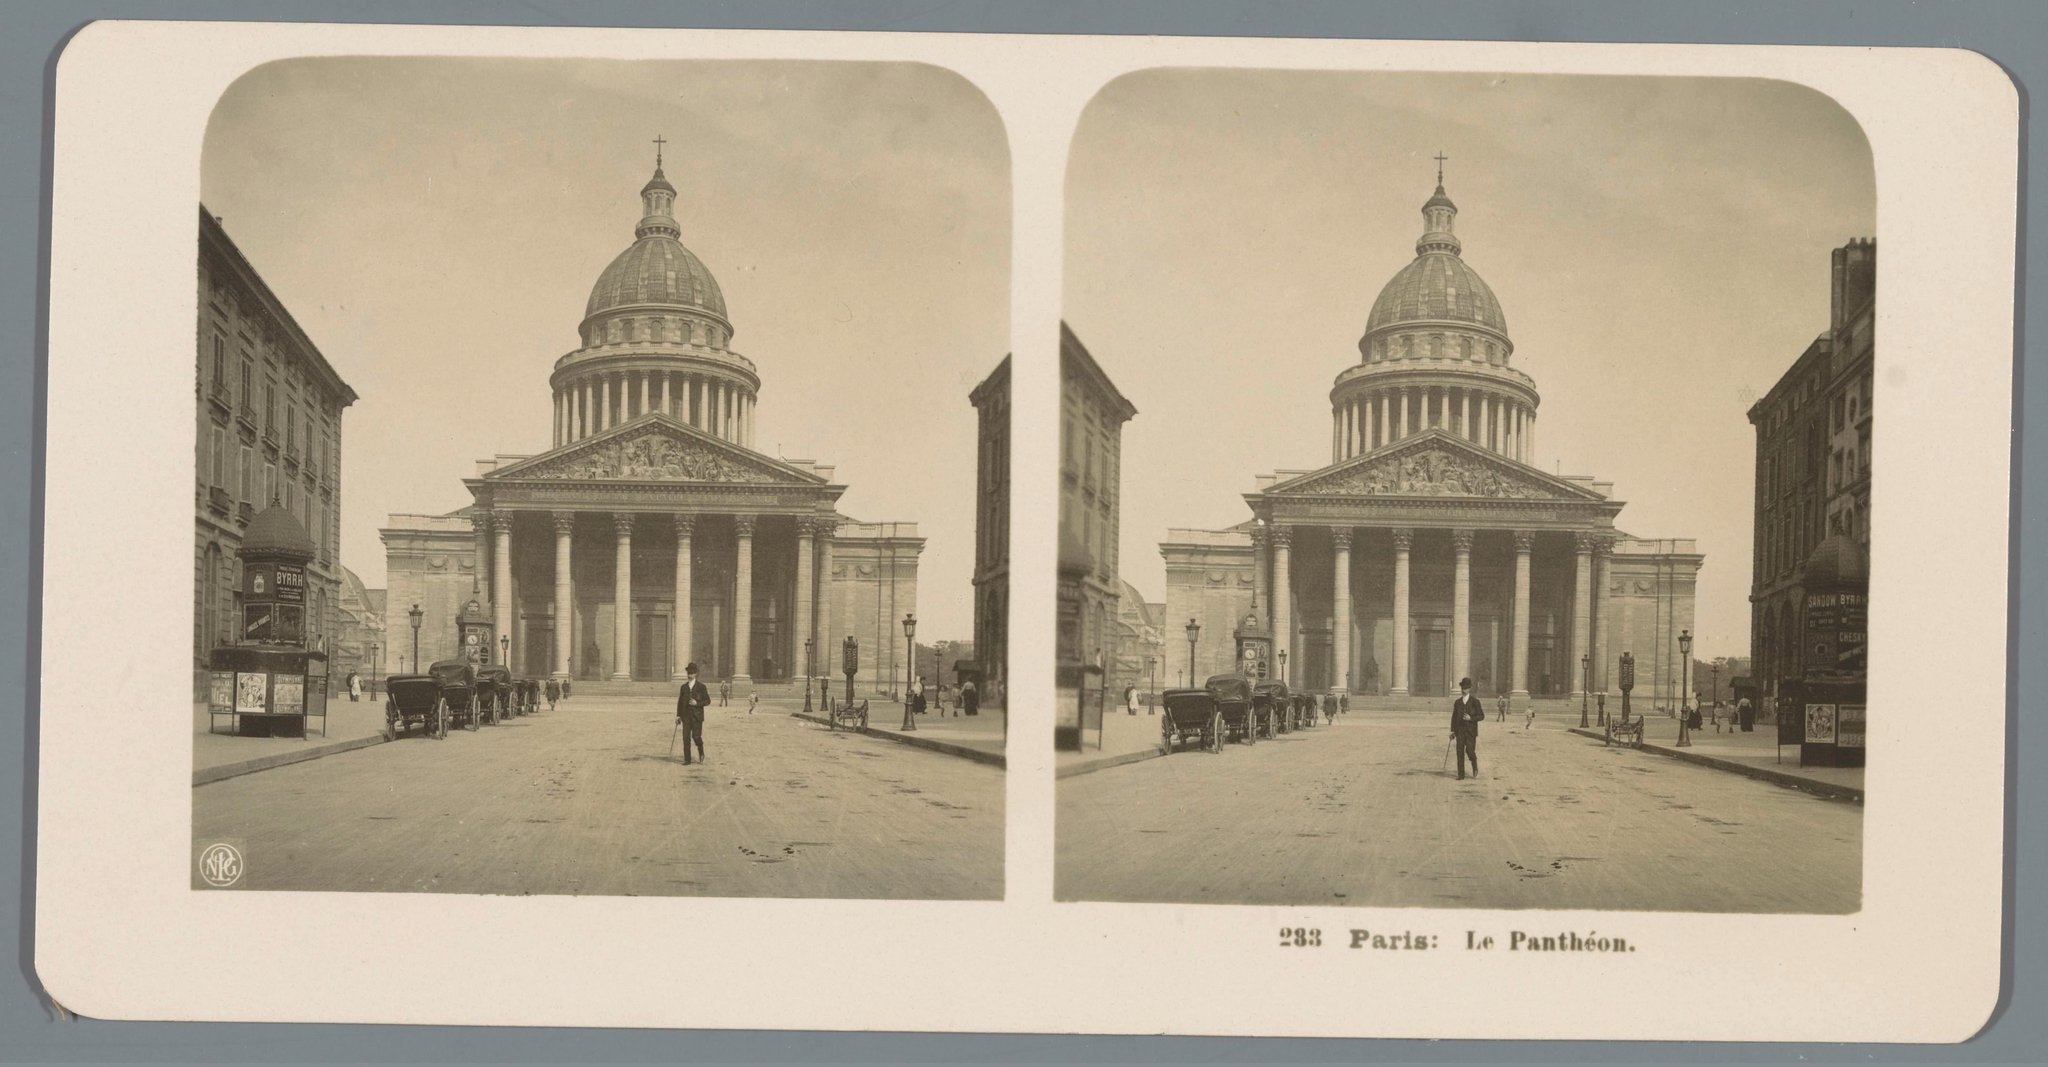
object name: stereograph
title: Gezicht op het Panthéon te Parijs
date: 1900-1905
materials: cardboard, photographic support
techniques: gelatin silver print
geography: paris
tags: other memorial structures, façade (of house or building), dome ~ architecture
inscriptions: number: ‘283’, inscription: ‘NPG’